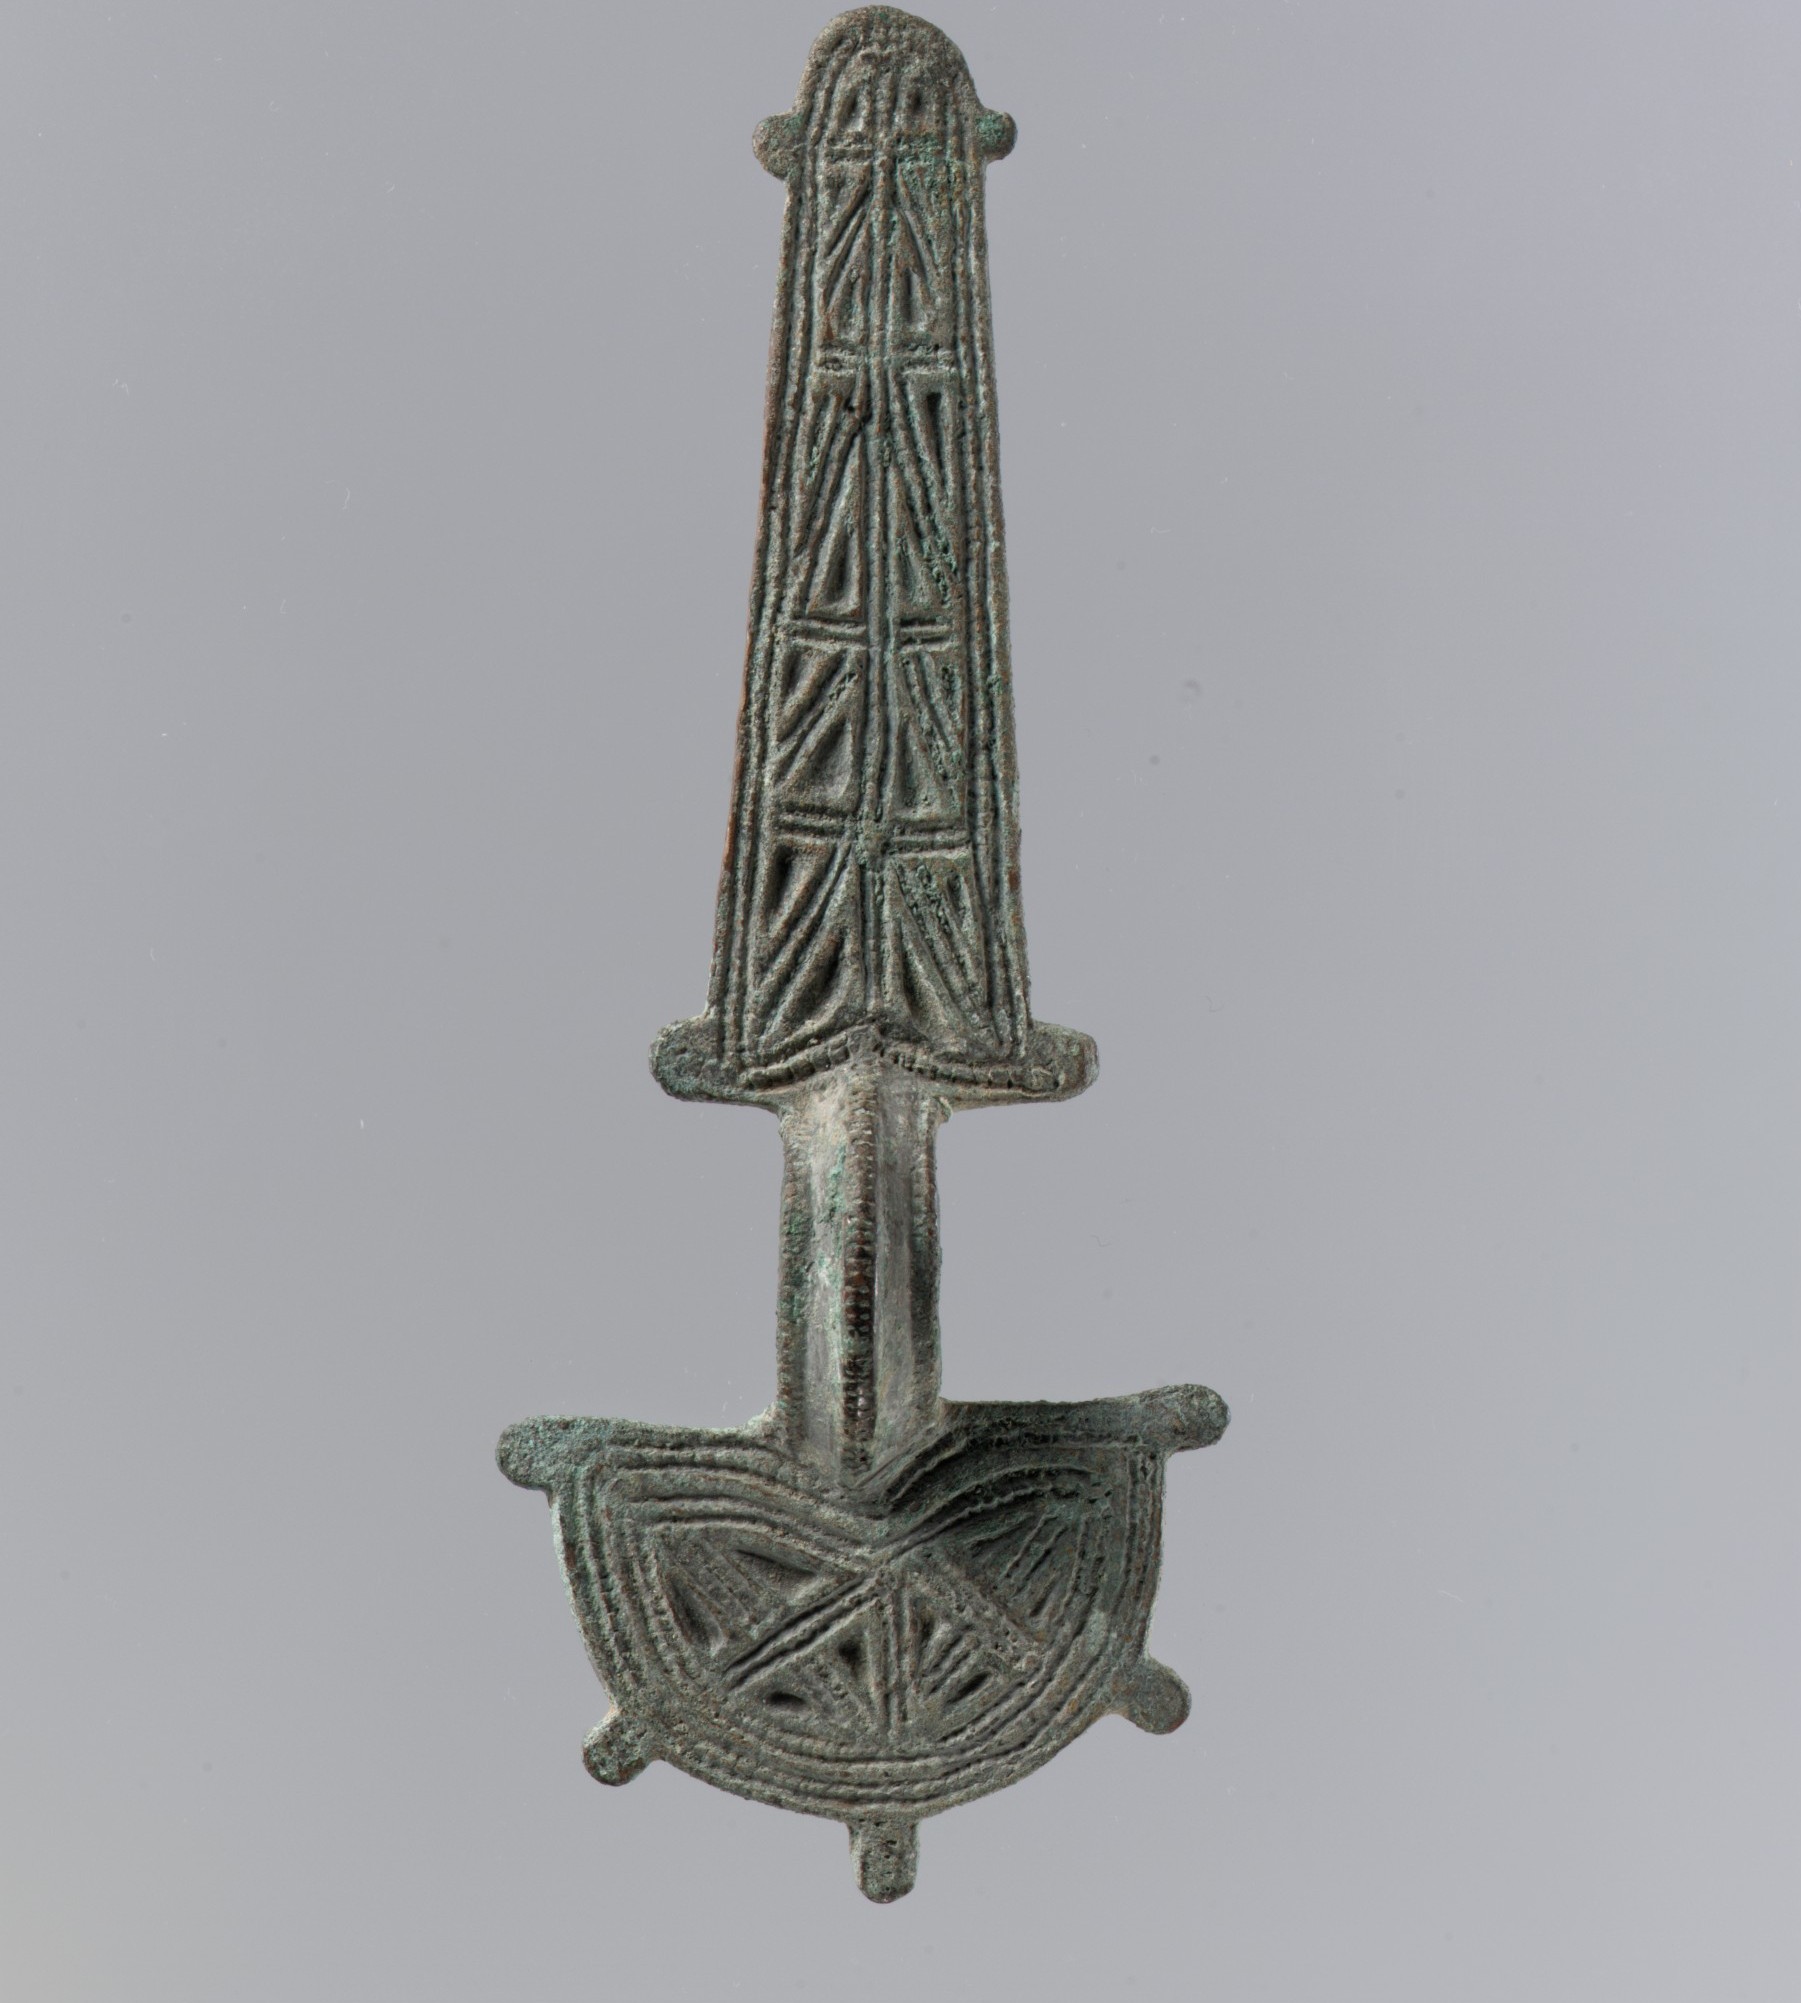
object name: brooch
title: Bow Brooch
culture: visigothic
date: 501-550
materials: copper alloy, iron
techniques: casting